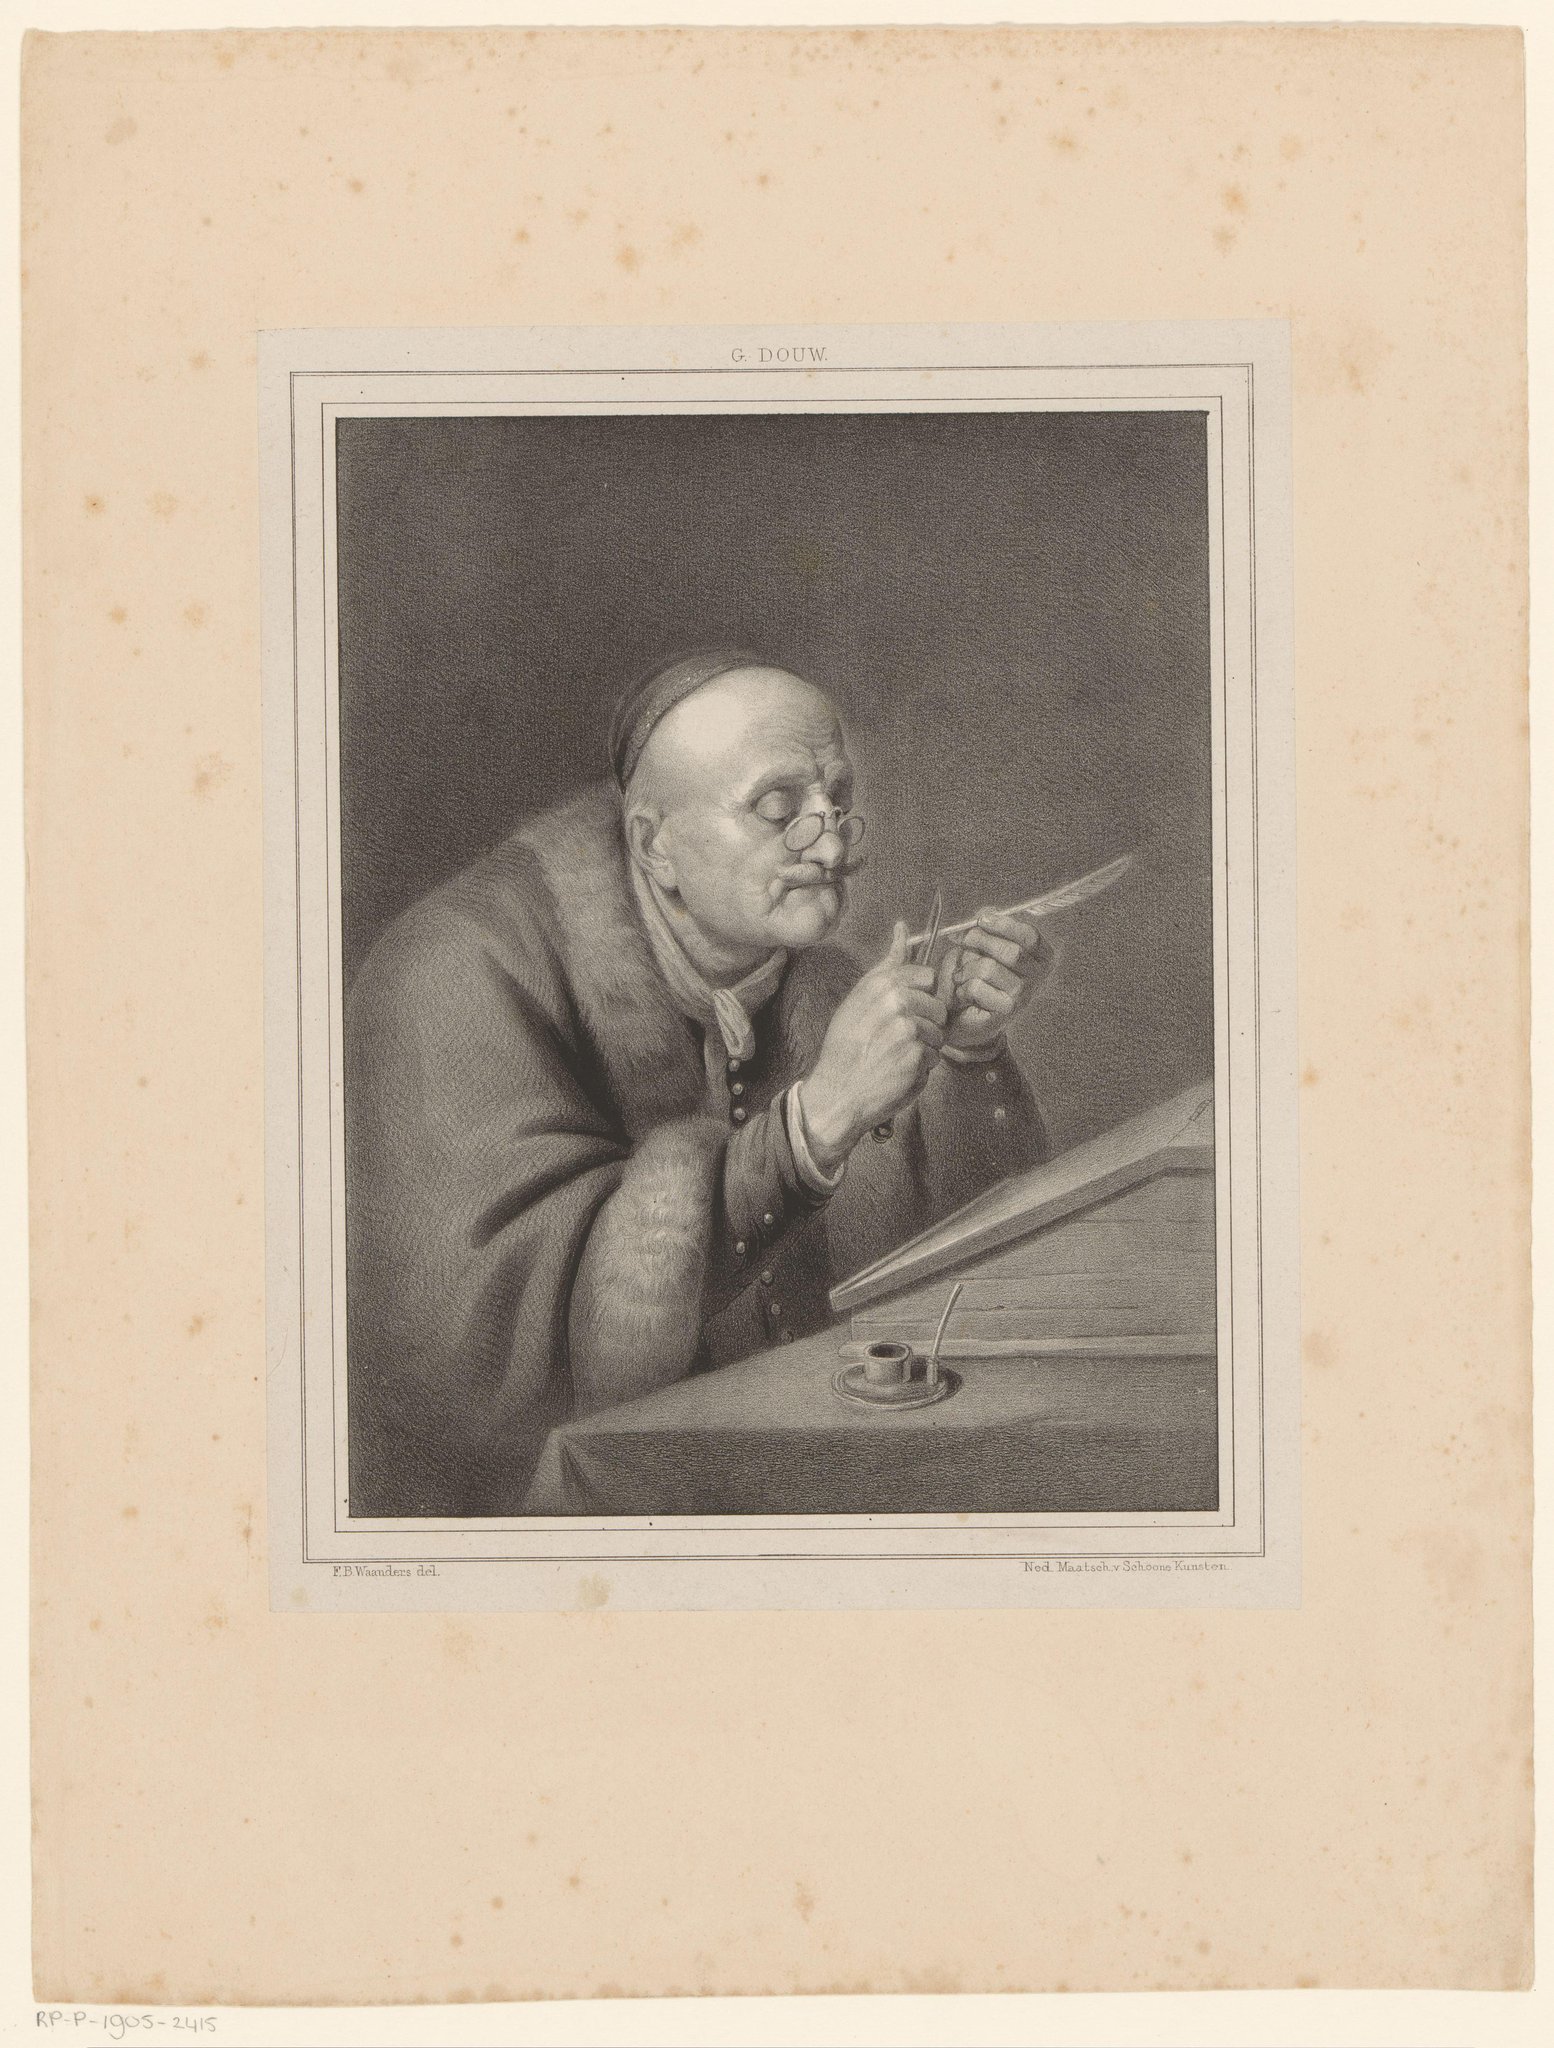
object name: print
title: Geleerde die zijn pen snijdt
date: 1840-1841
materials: paper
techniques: lithograph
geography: the hague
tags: sharpening pen (quill)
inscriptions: collector's mark: Lugt 2228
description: Naar Geleerde die zijn pen snijdt (1630-1635) van Gerard Dou in de Leiden Collection te New York. Prent uit Kunstkronijk, 1840-41.